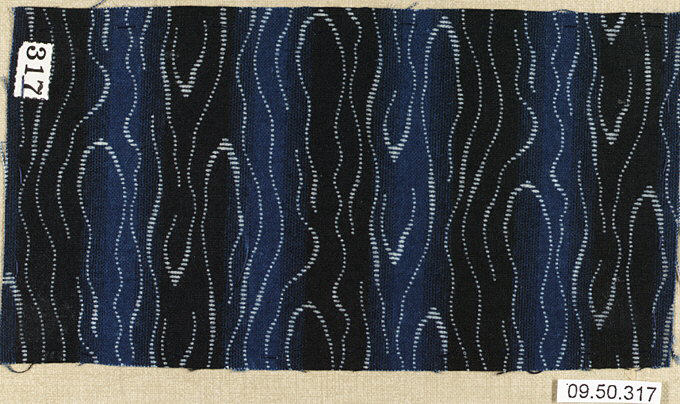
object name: piece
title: Piece (one of 116)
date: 1801-1900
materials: cotton